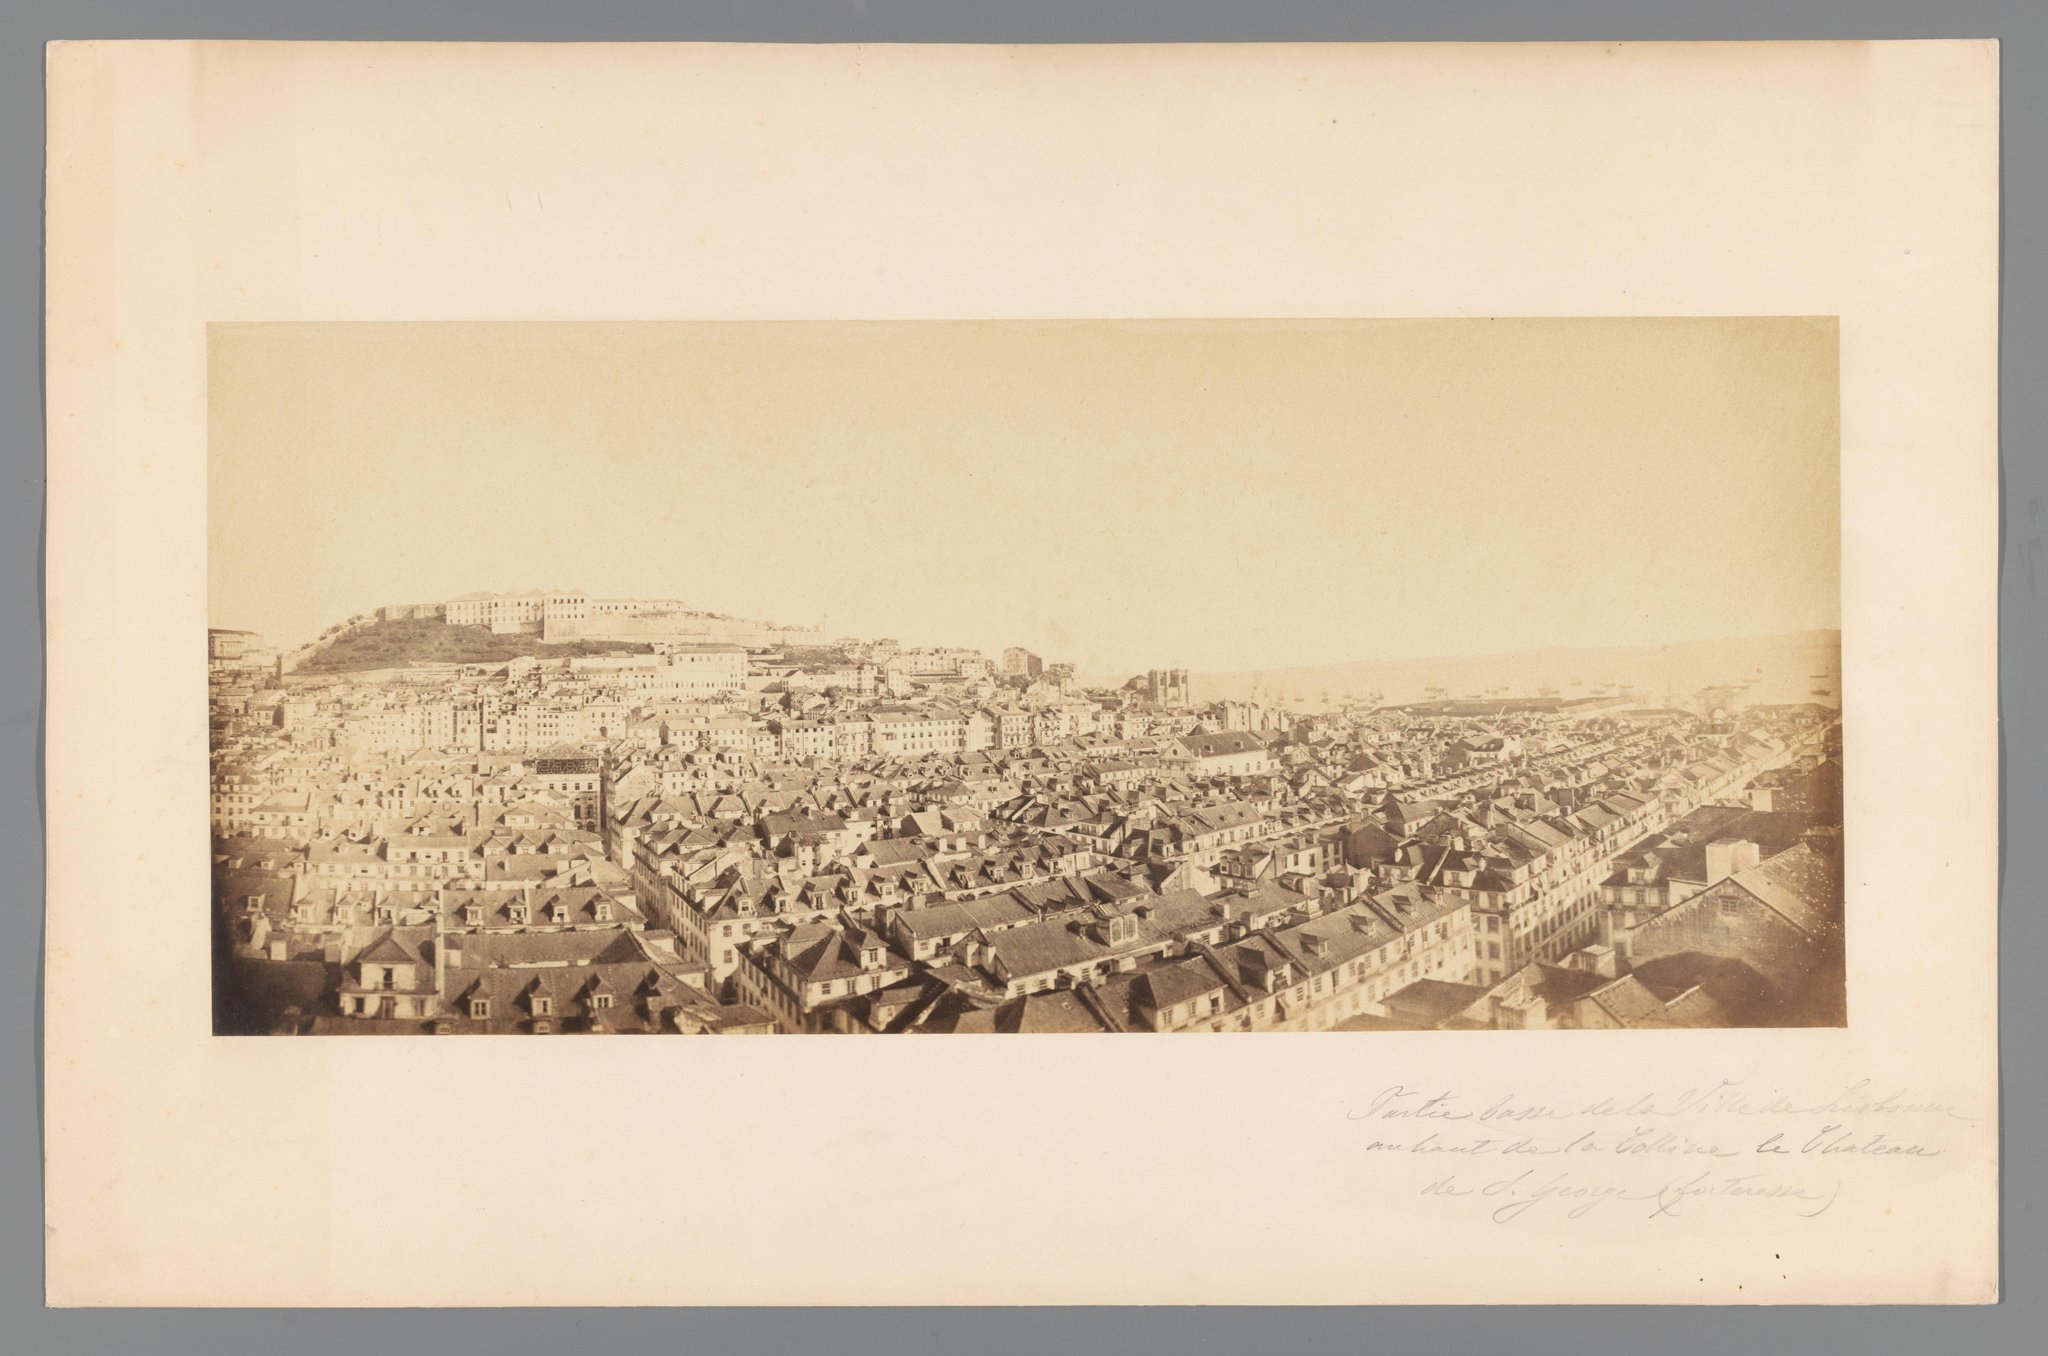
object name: photograph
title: Panorama kijkend op de oude stad Lissabon, met gezicht op de heuvel met Kasteel S. George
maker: Anonymous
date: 1870-1890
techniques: albumen print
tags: lissabon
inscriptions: inscription